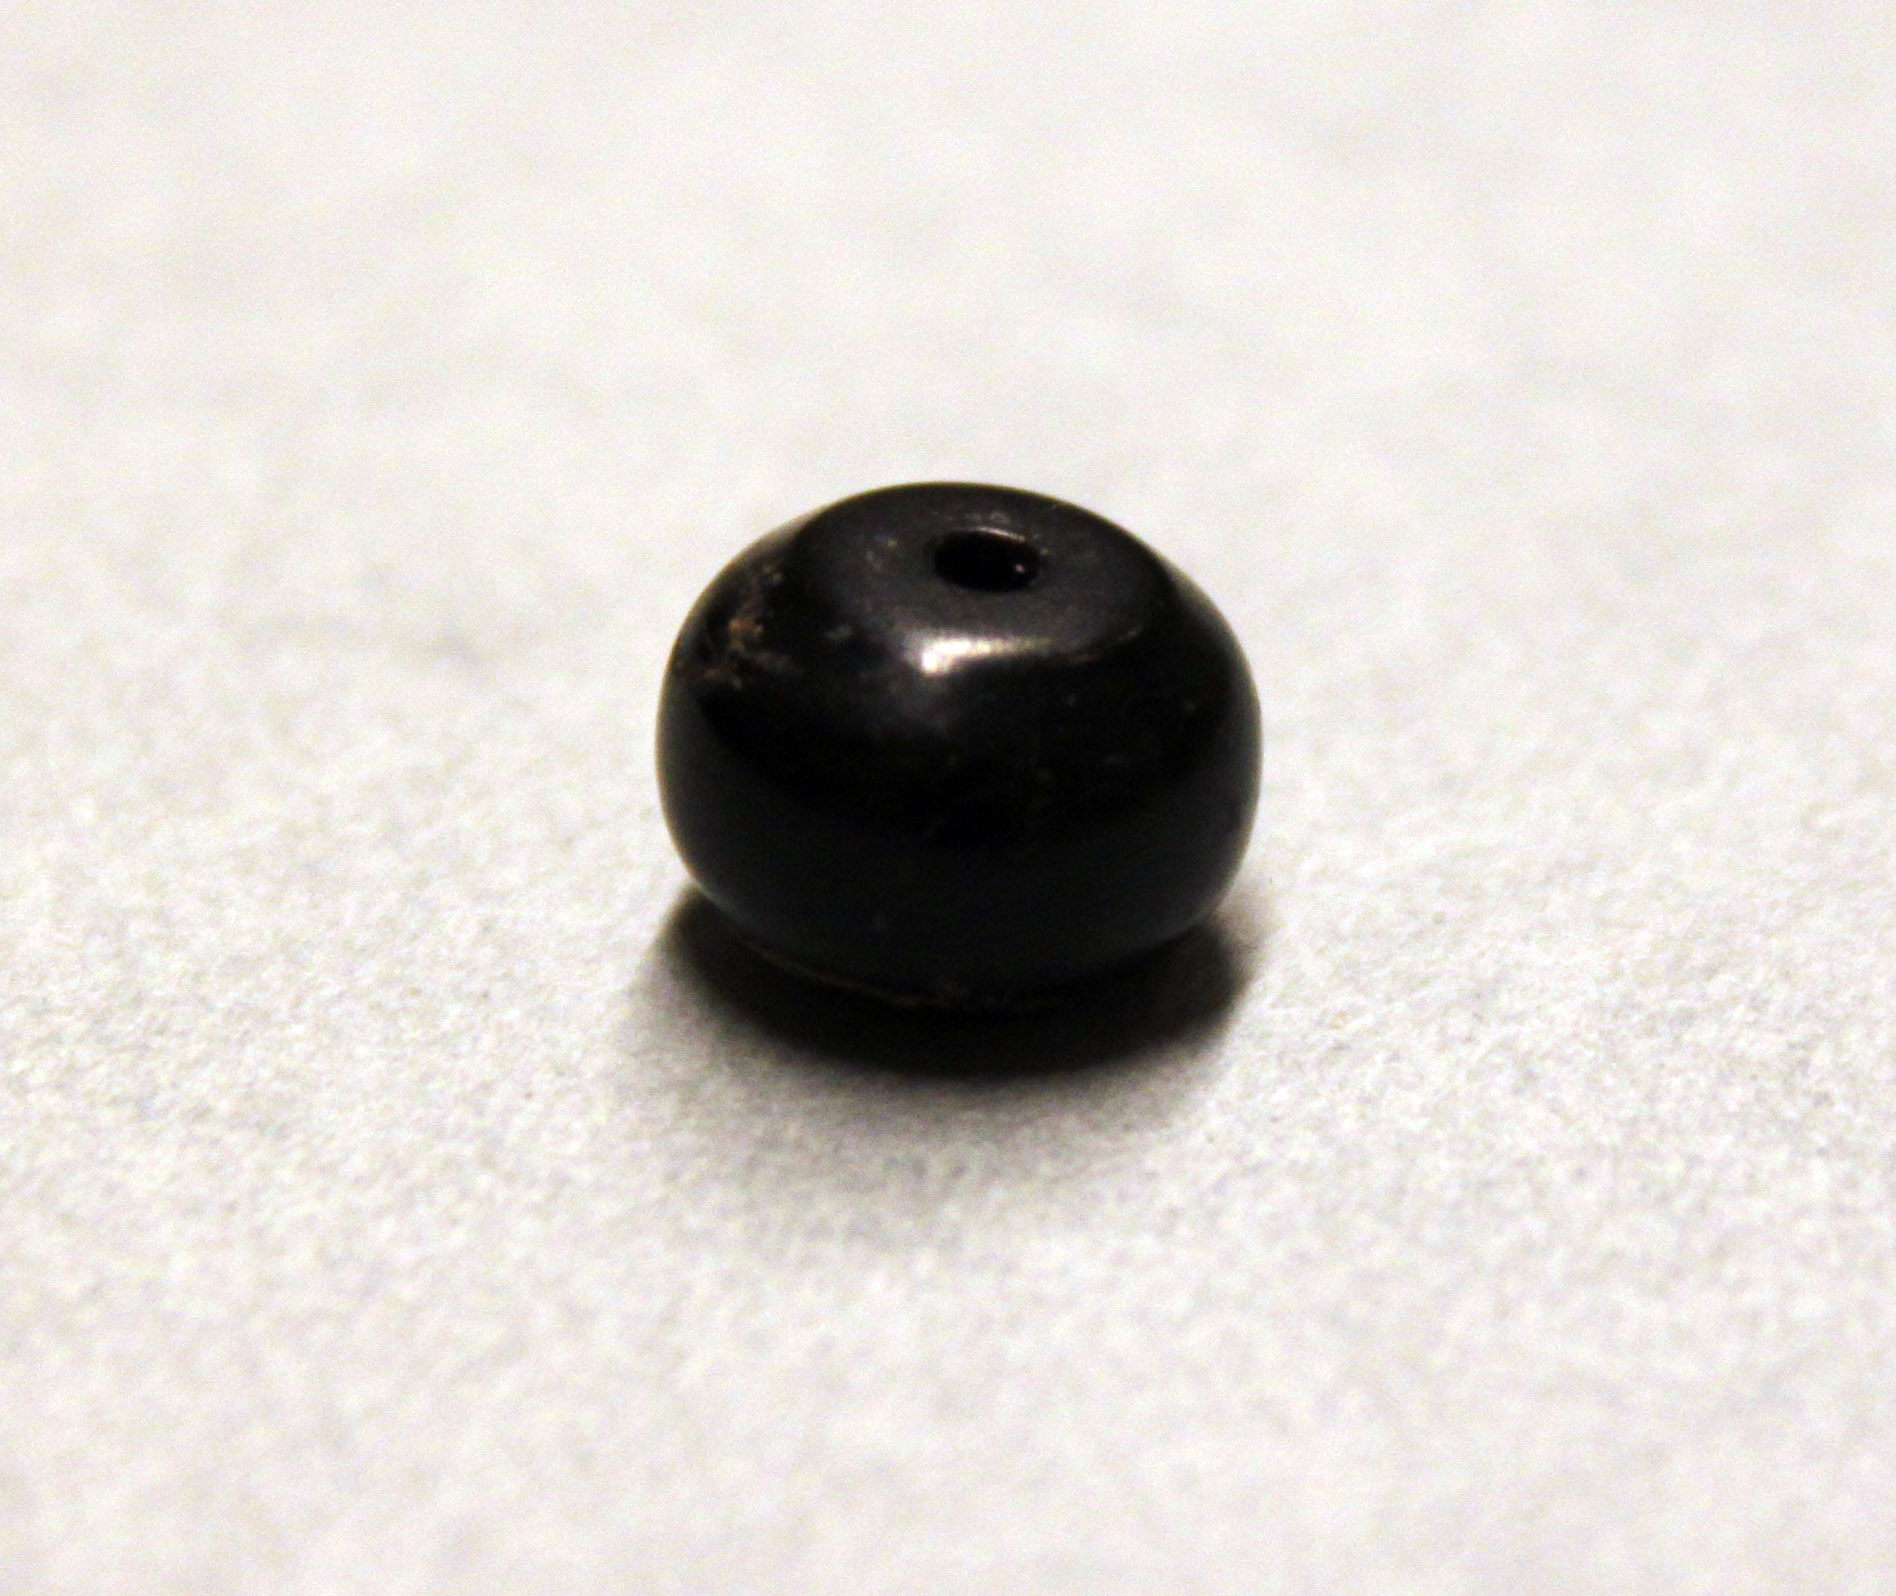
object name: bead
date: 701-1300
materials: stone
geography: iran